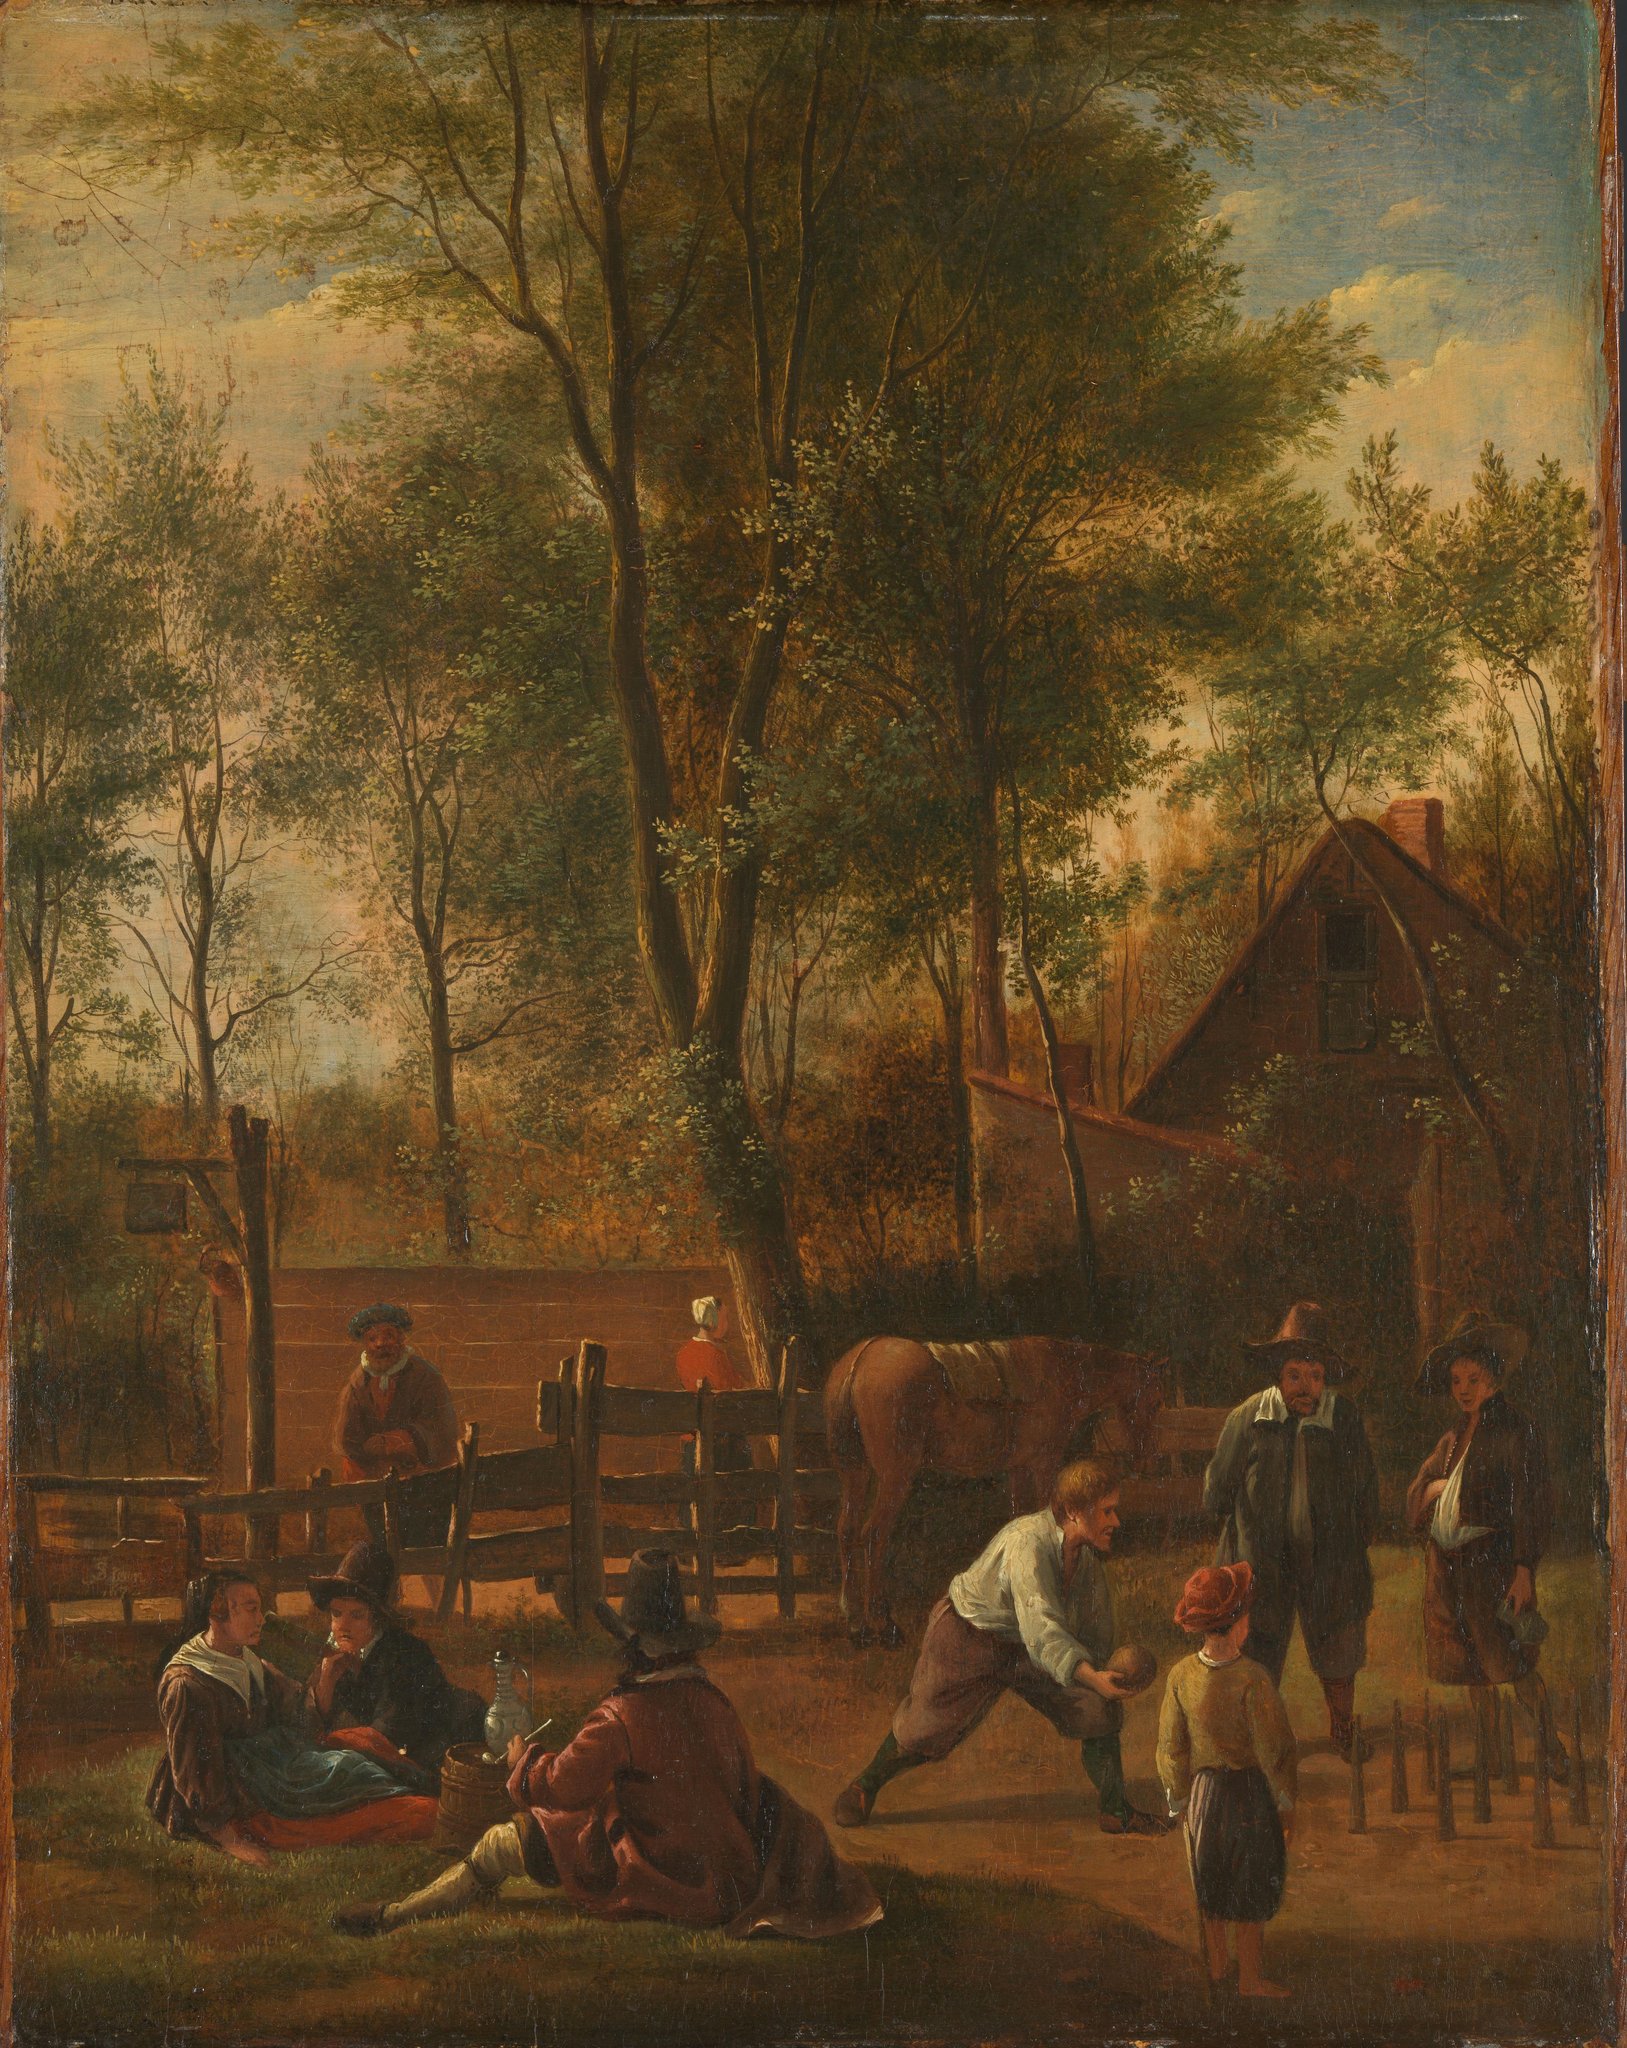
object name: painting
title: The bowlers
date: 1658-1700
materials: oil, panel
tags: pavement, terrace in front of inn or restaurant, ninepins, skittles, ball games in which ball or bowl is rolled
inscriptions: signature and date: ‘J.Steen 1672’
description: De kegelaars. Enkele mannen kegelen op een baan buiten een herberg. Links zitten twee mannen en een vrouw in het gras. Kopie naar het origineel in de National Gallery te Londen.